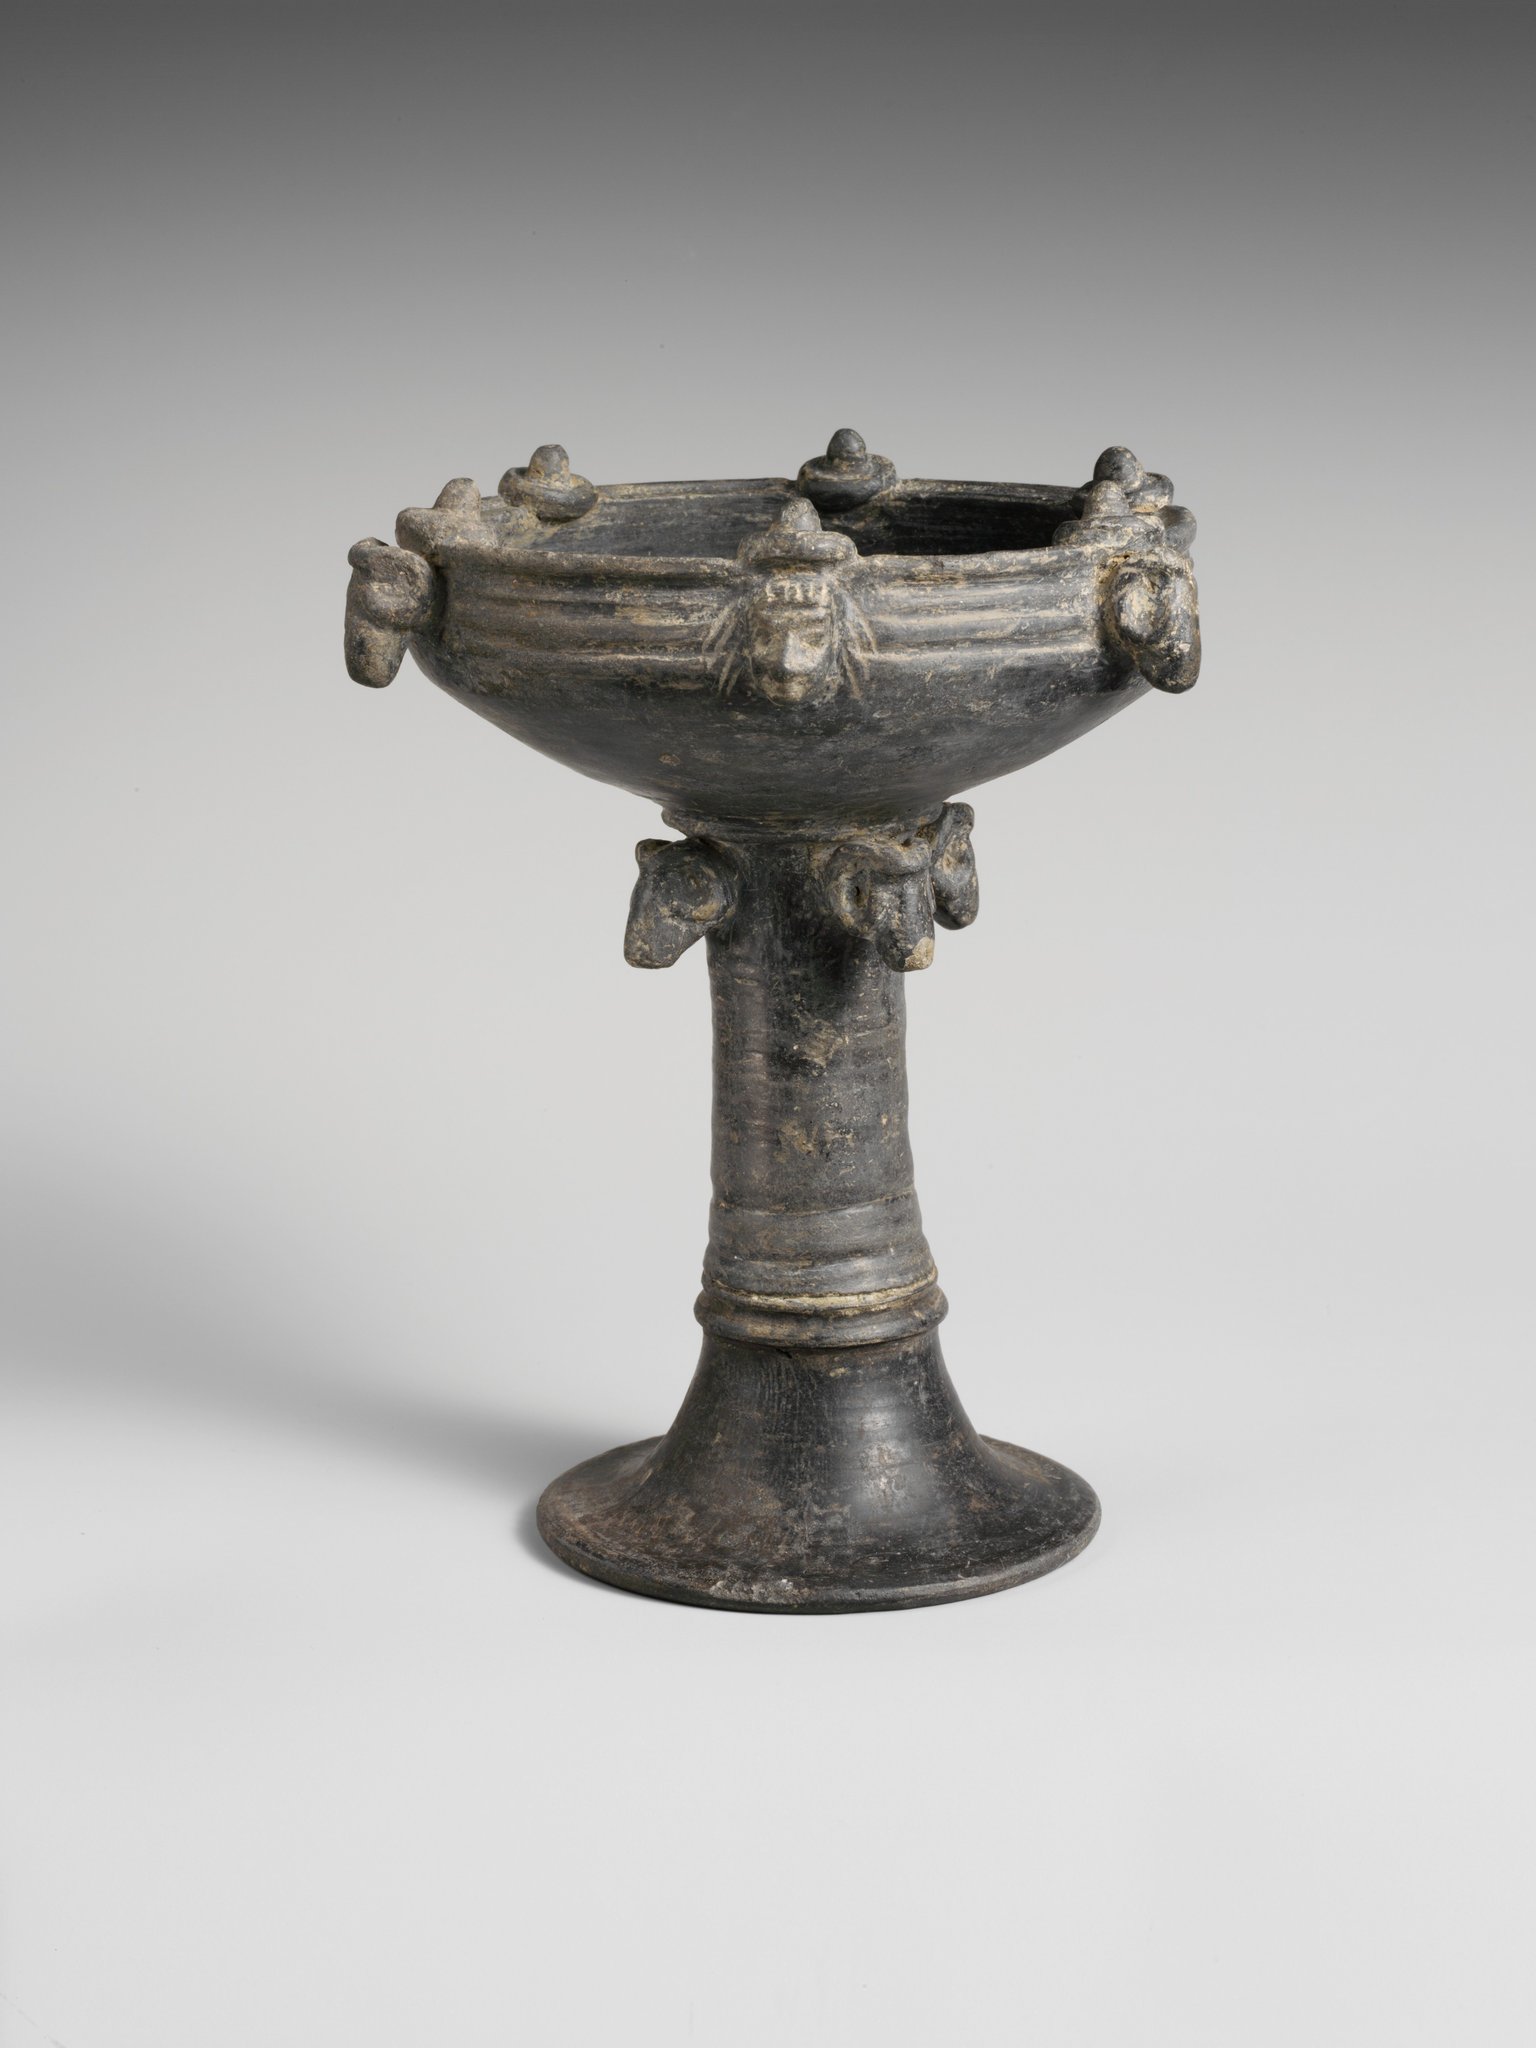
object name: cup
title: Terracotta chalice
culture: etruscan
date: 575-550 BCE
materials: terracotta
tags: rams